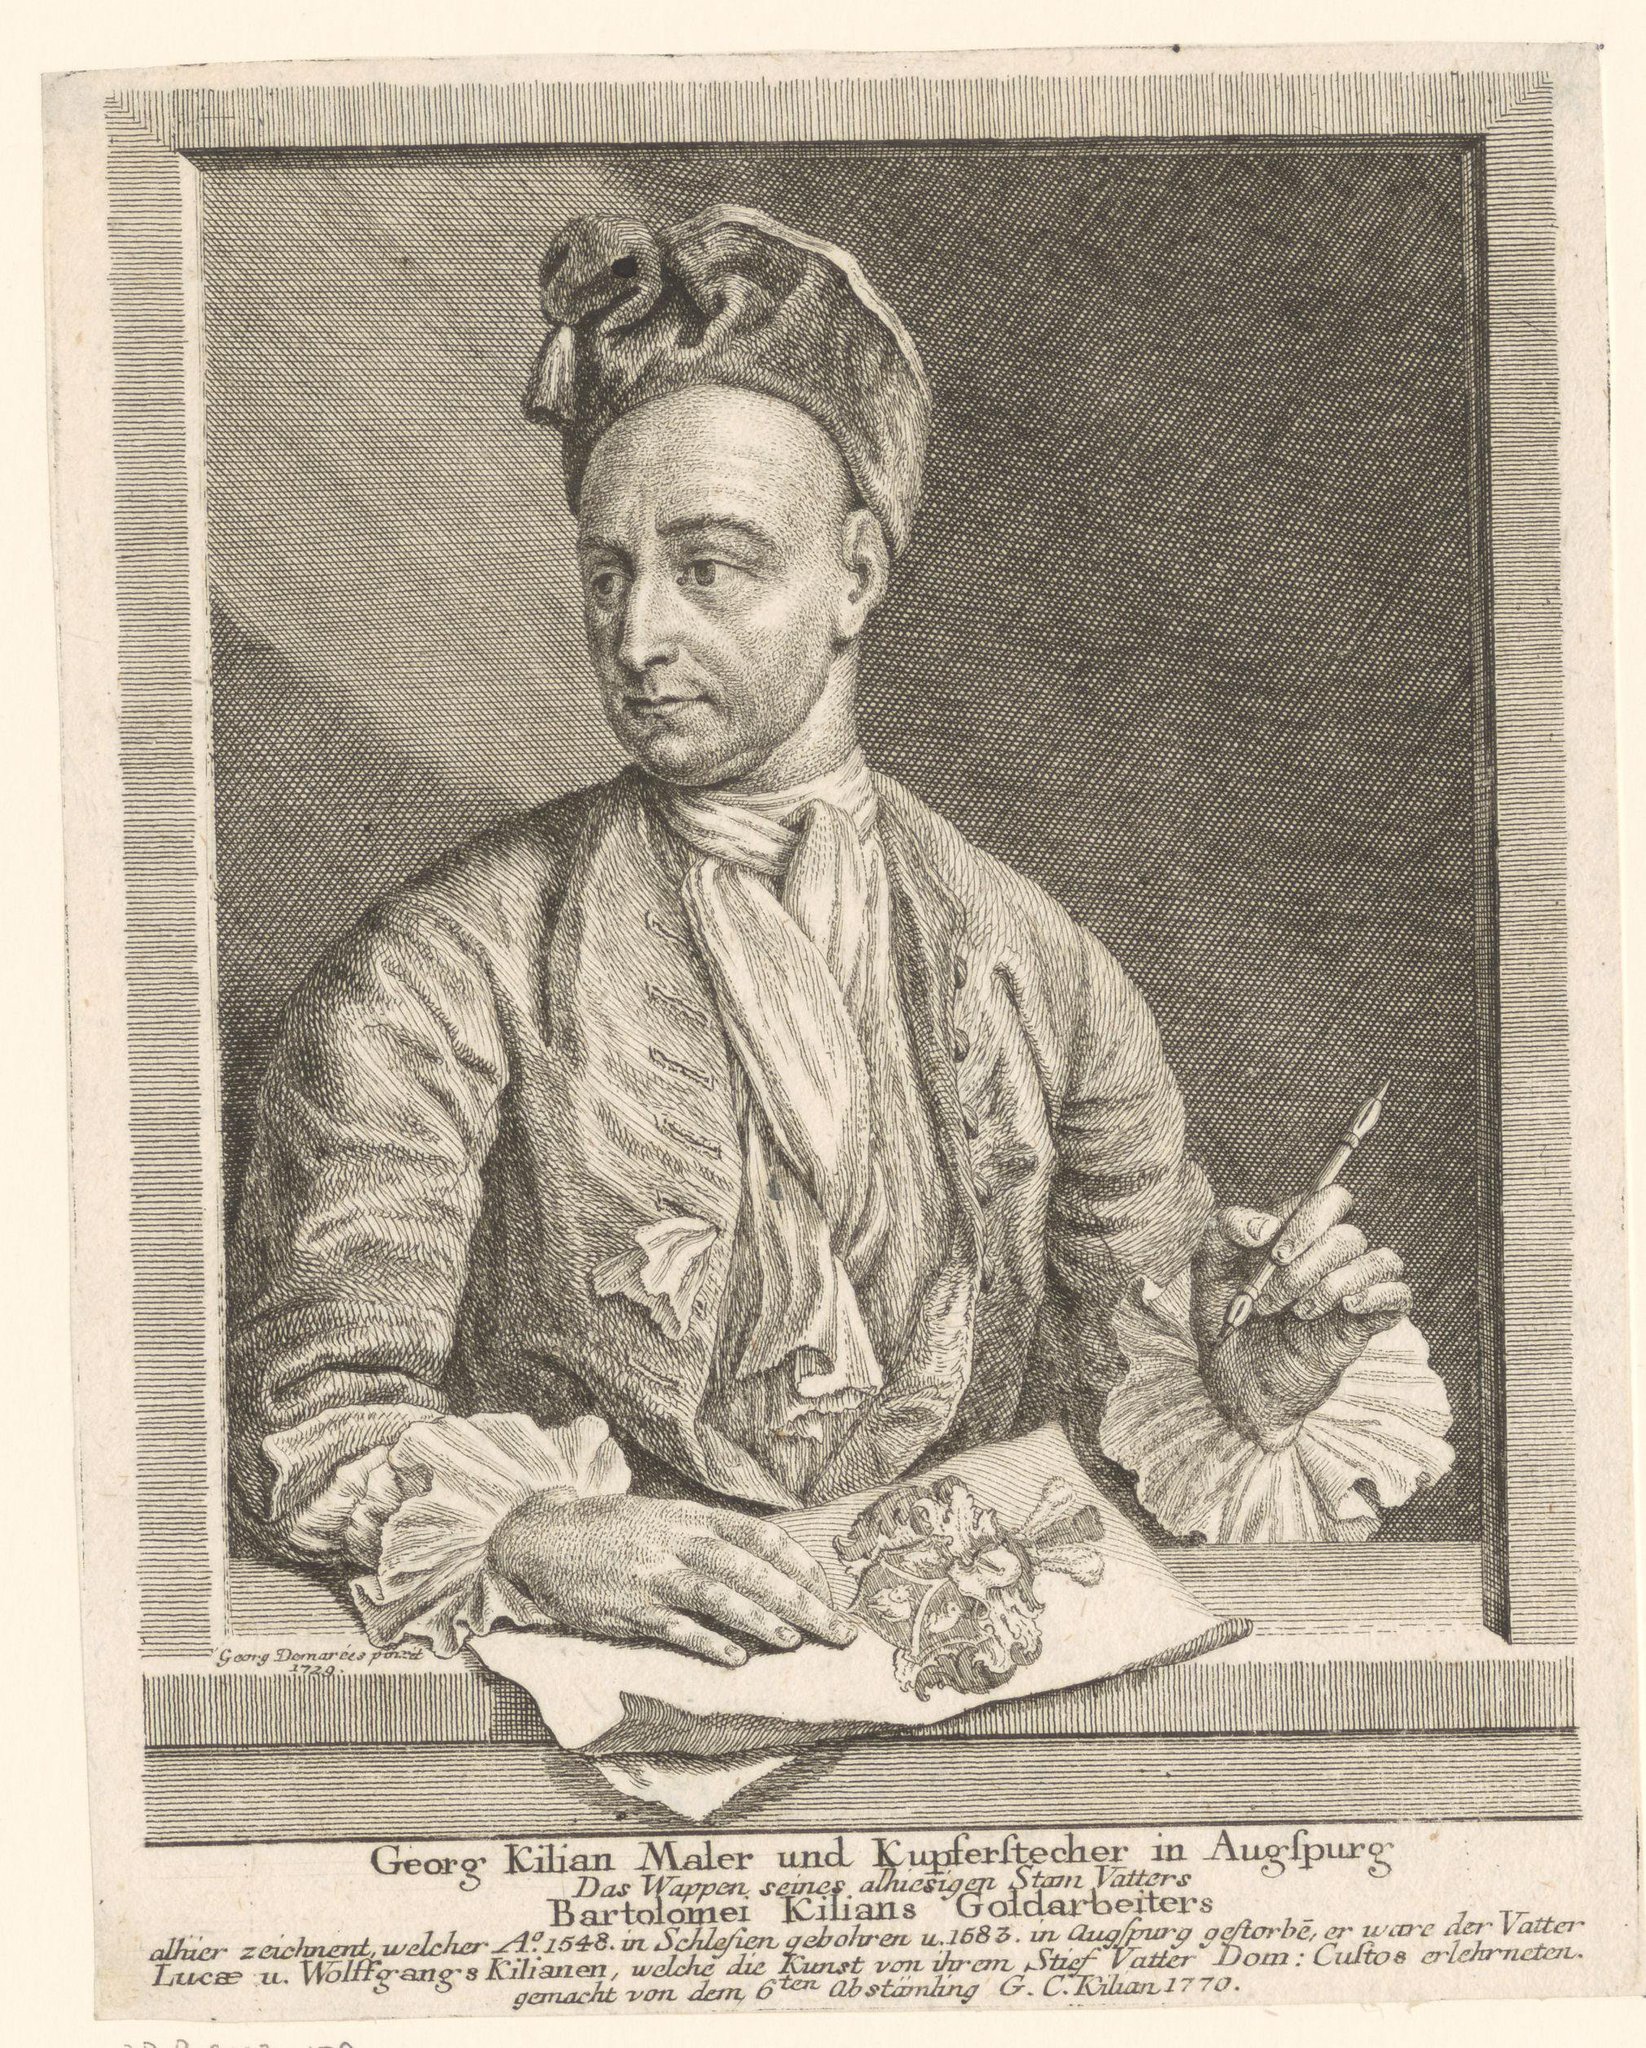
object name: print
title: Portret van Georg Kilian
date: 1770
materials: paper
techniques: etching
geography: augsburg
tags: augsburg, georg kilian, historical persons, portrait, self-portrait of graphic artist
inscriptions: collector's mark: Lugt 2228, collector's mark: Lugt 2760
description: Op het blad onder Kilians rechterhand staat zijn familiewapen afgebeeld. Tekst in het Duits in de marge onderin.